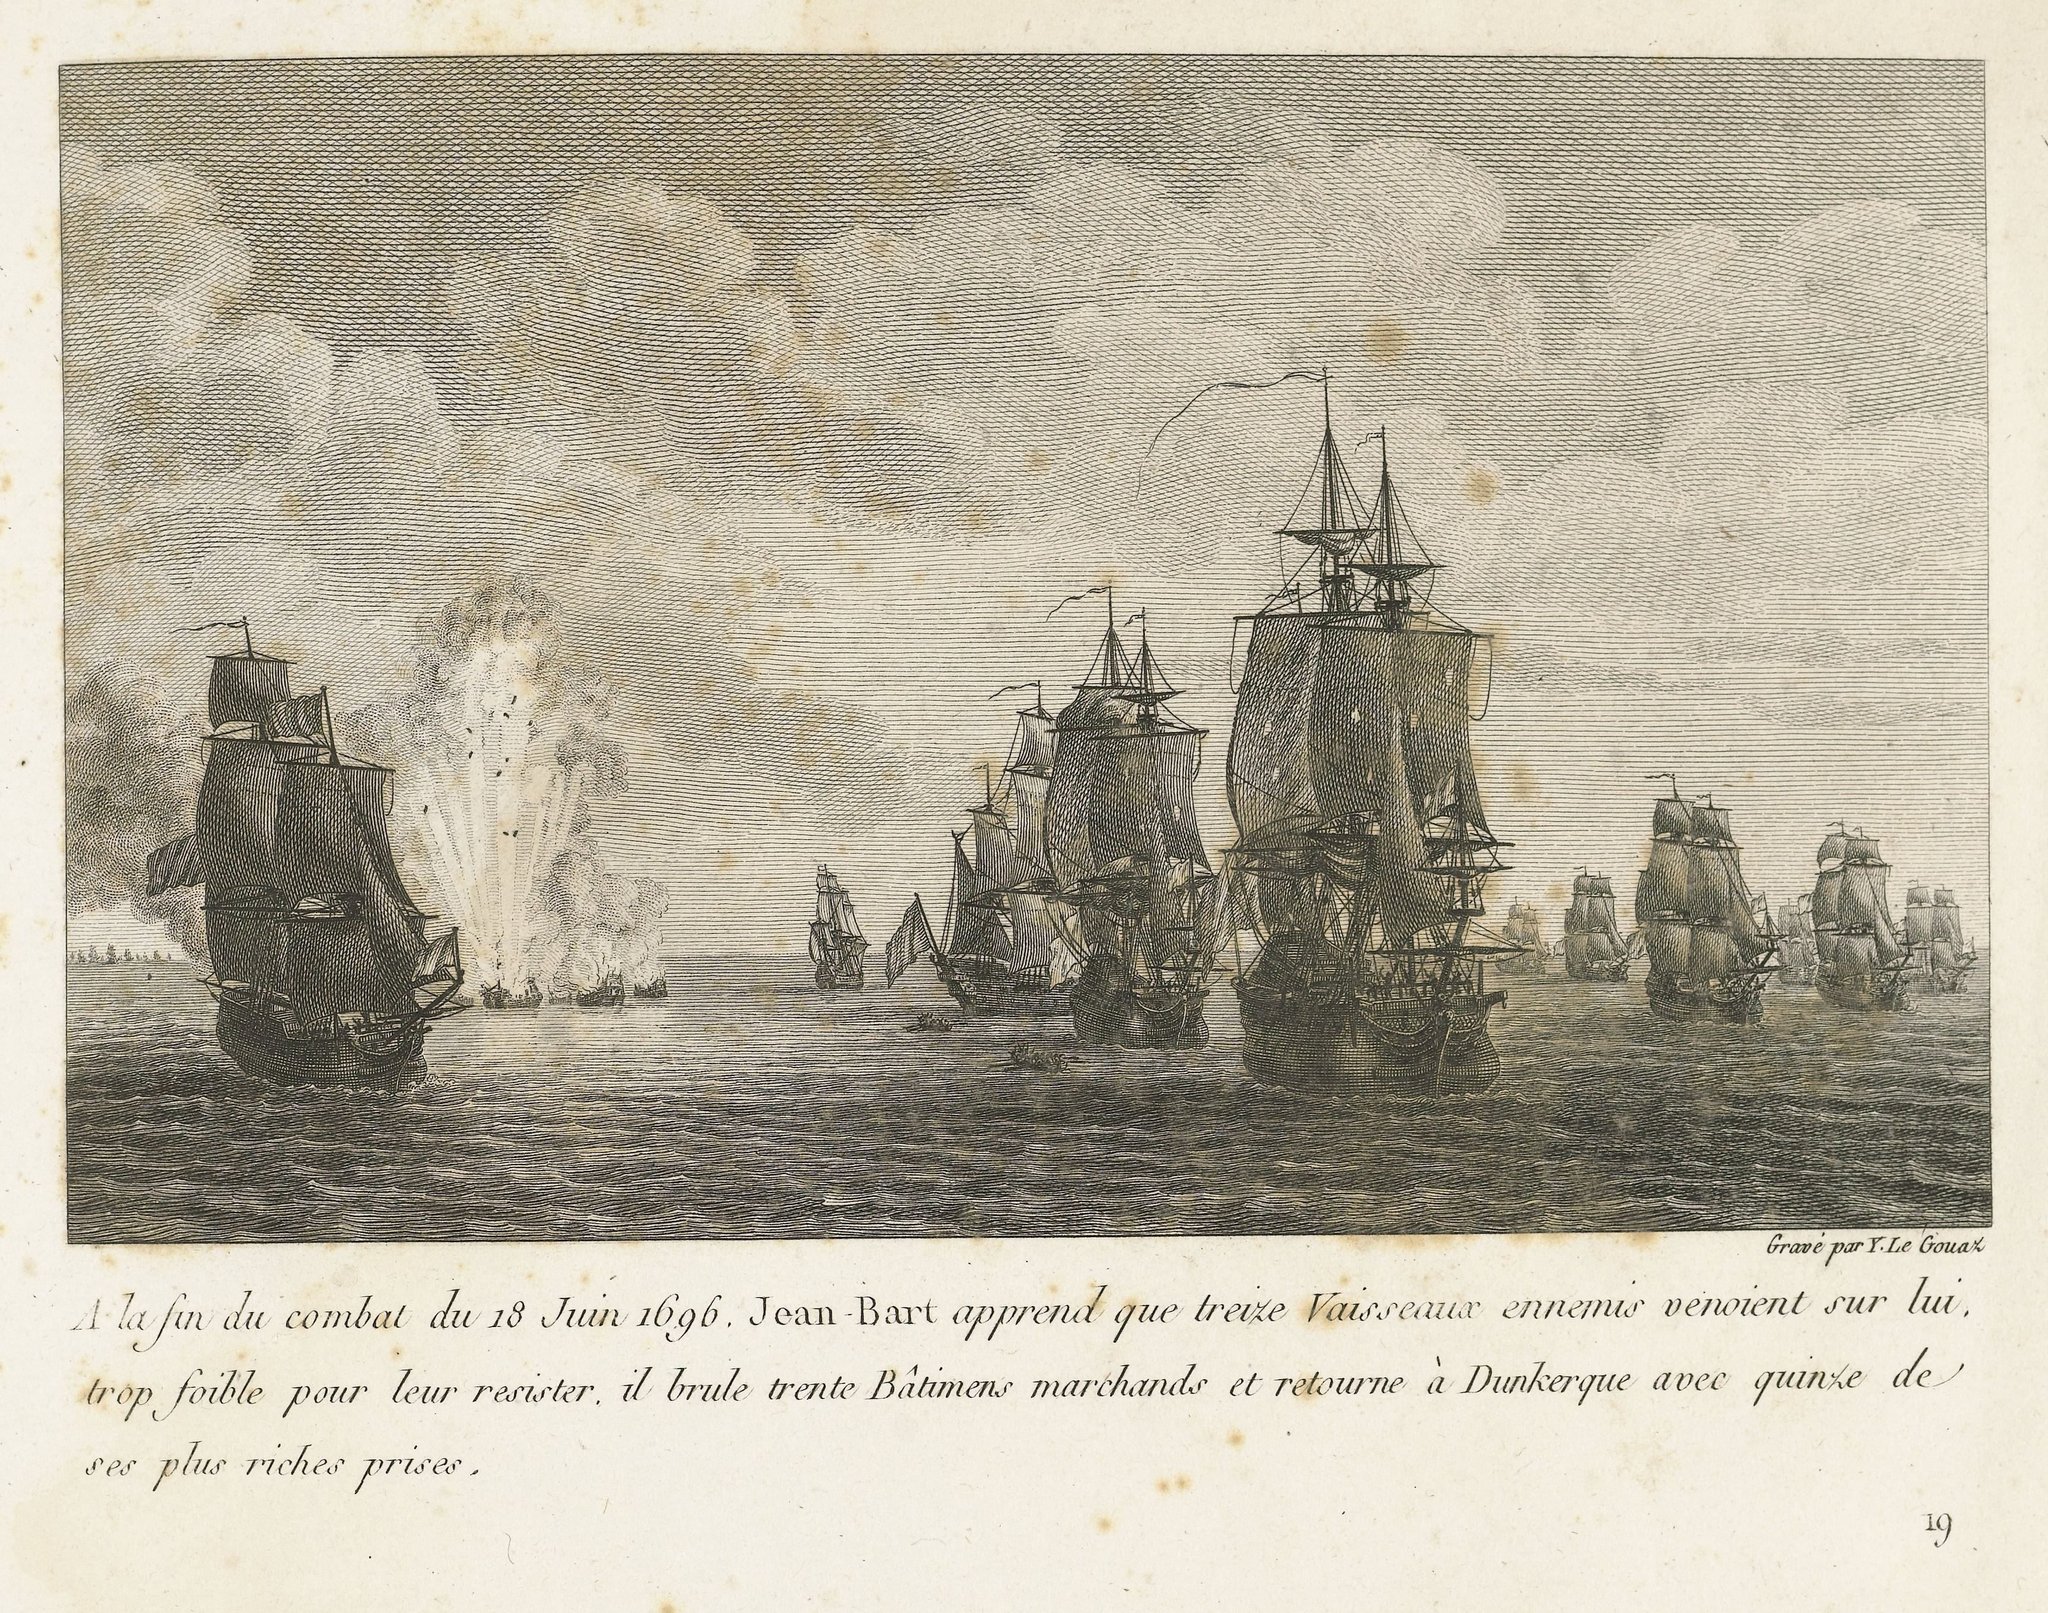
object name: history print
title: Recueil des combats de Jean-Bart, chef d'Escadre sous Louis XIV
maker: yves marie le gouaz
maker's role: print maker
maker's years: 1742-1816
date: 1806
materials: paper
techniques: etching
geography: paris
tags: battle (+ naval force)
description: Treffen tussen een vloot onder Jan Bart en een Hollandse vloot, 18 juni 1696. Onderdeel van een serie over de daden van de Vlaamse kaper in Franse dienst Jan Bart.